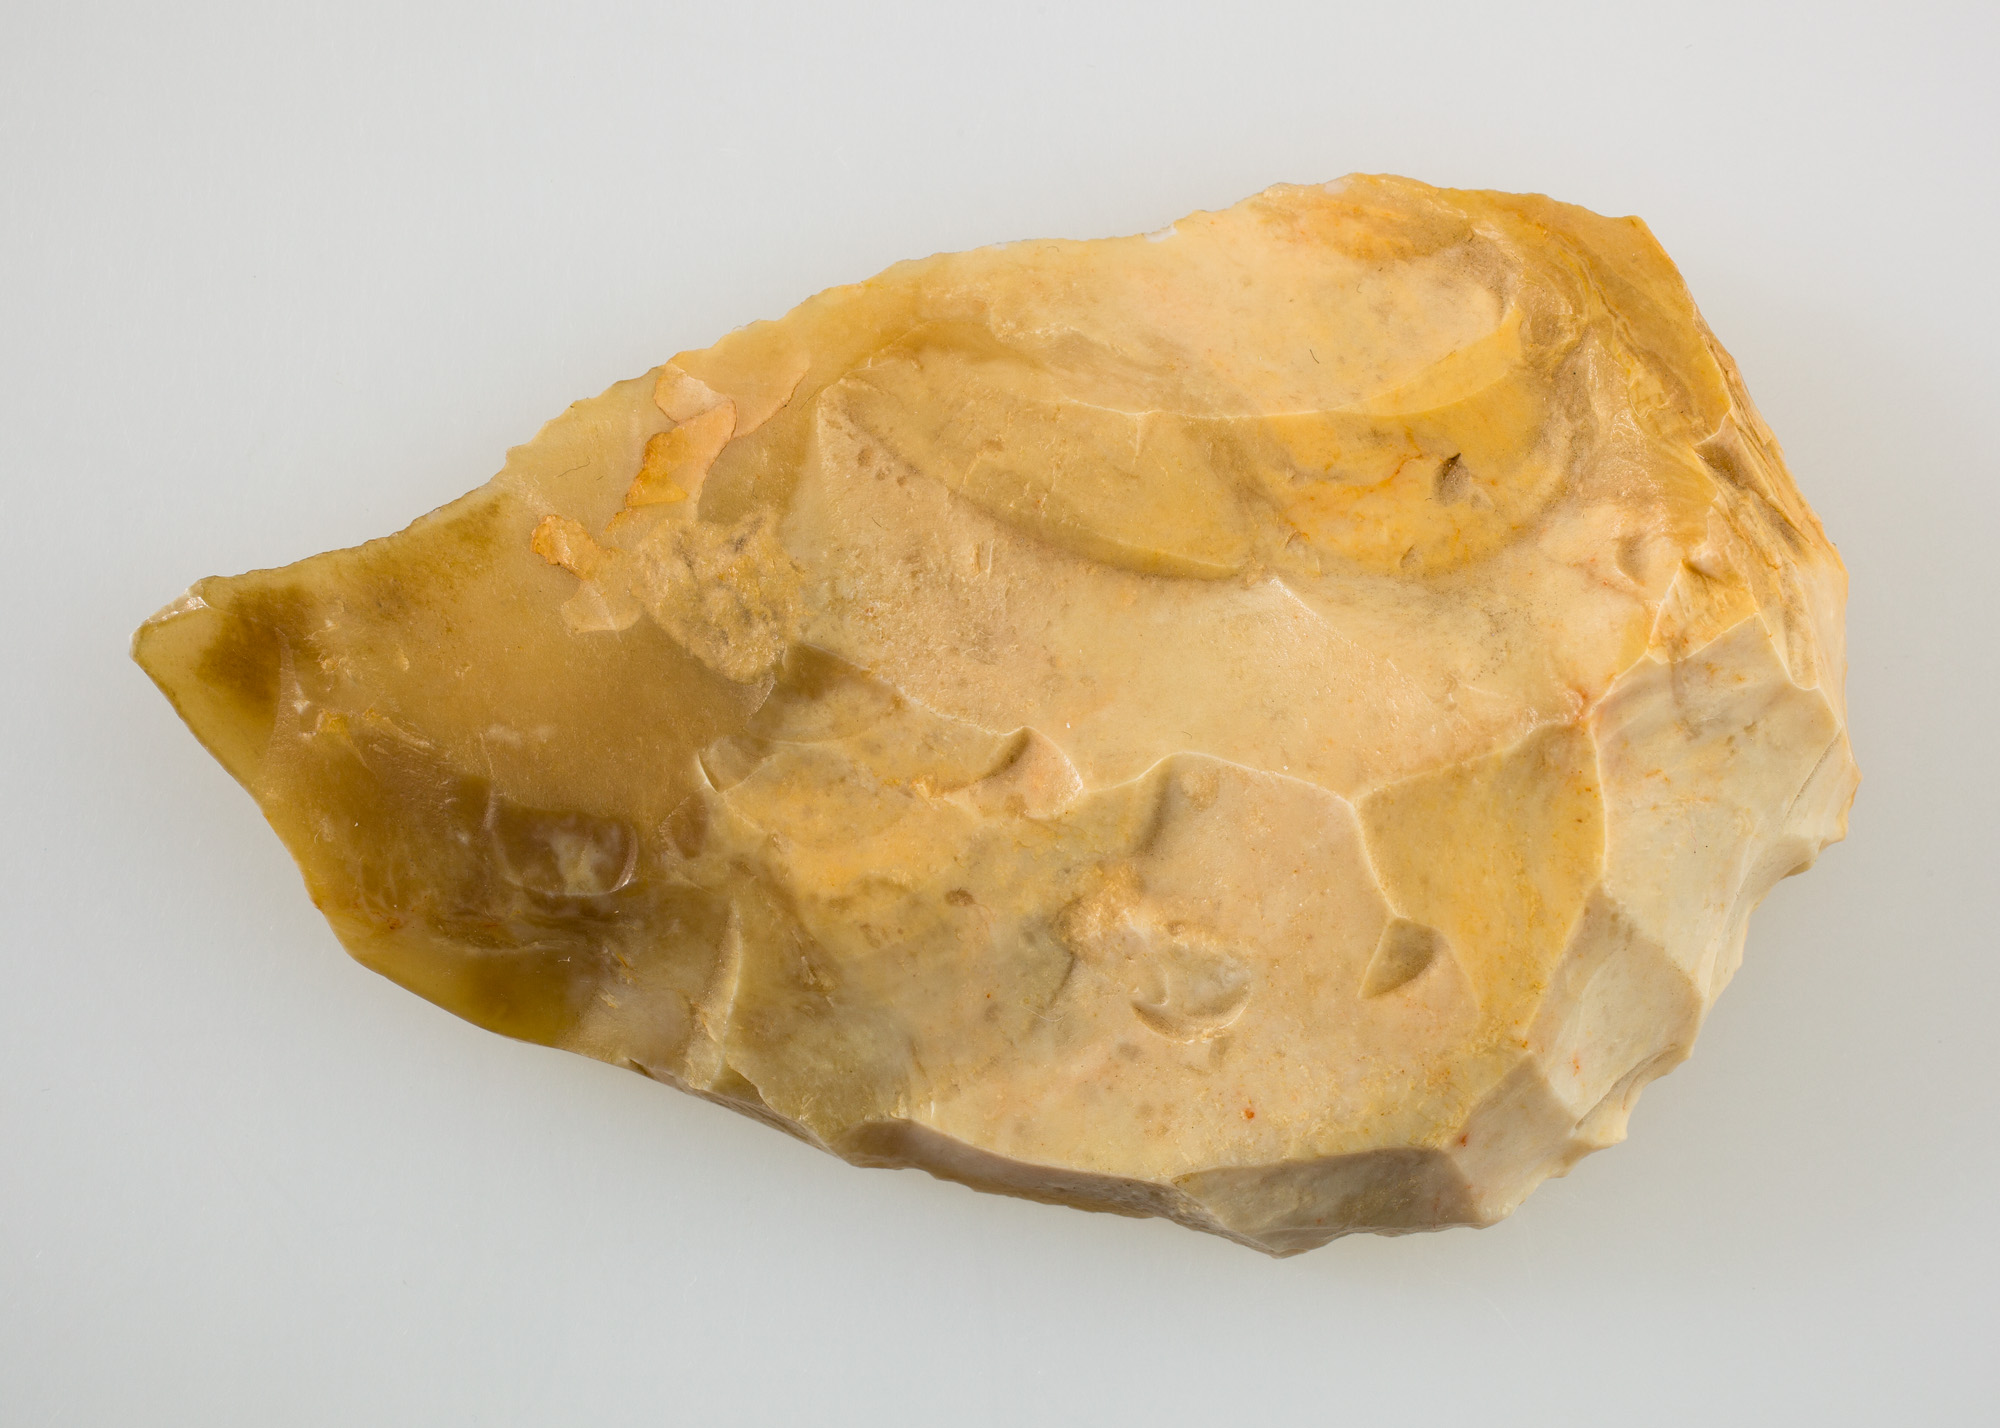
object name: scraper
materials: stone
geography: egypt